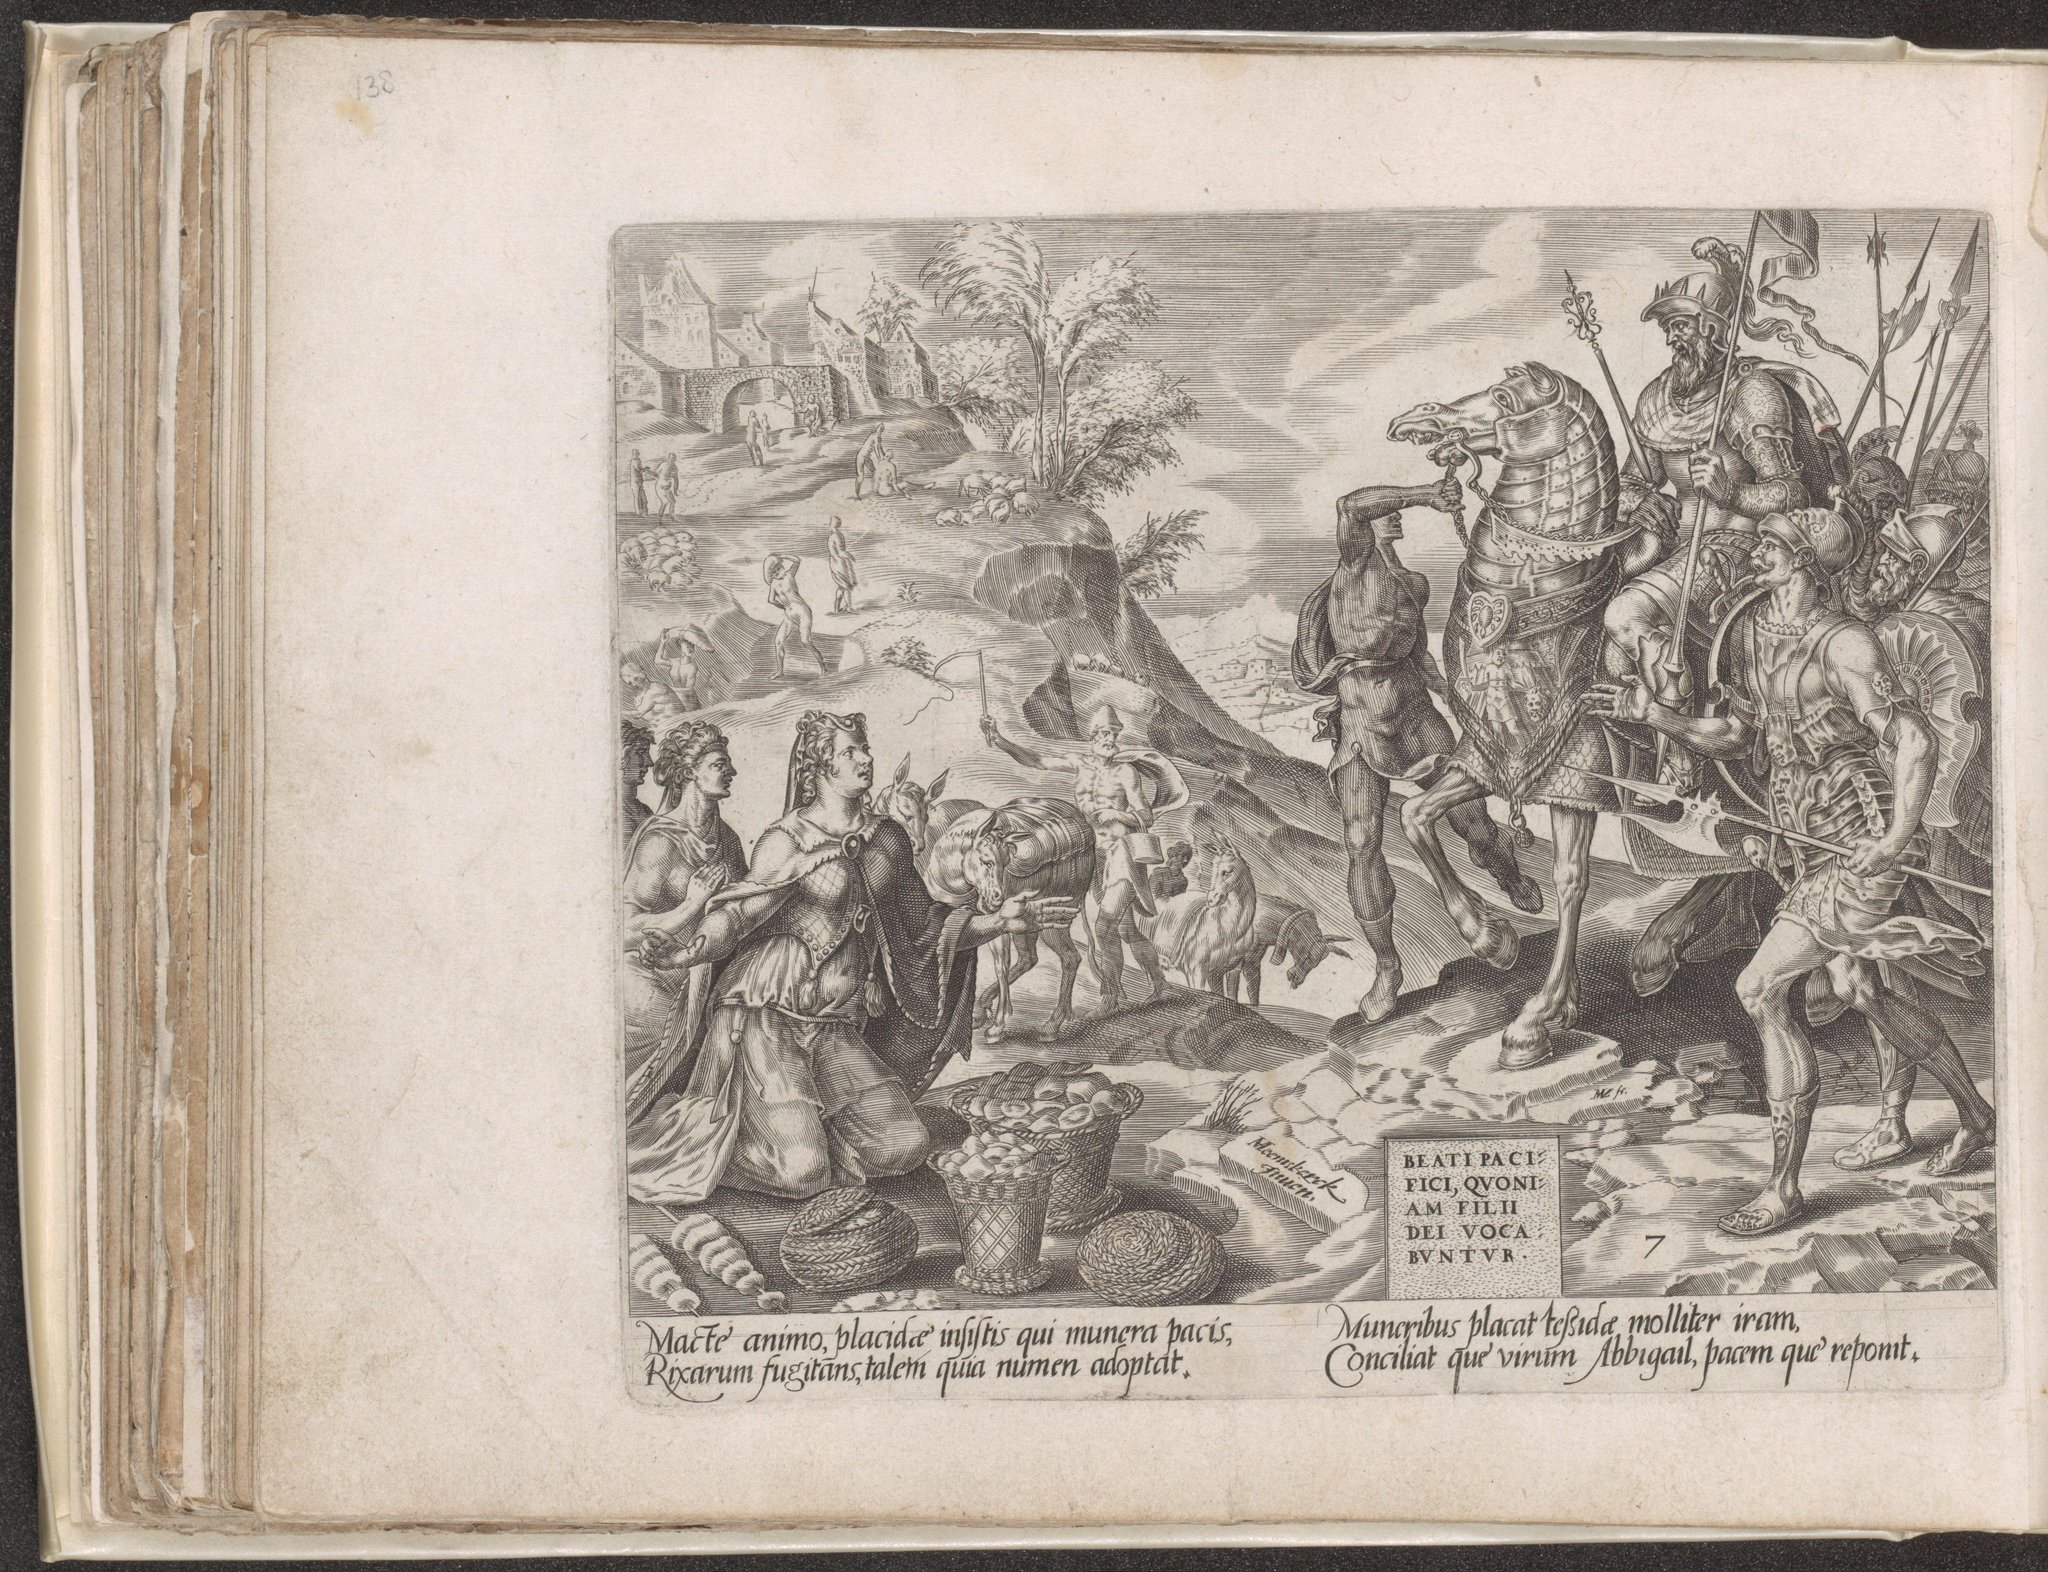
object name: print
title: David en Abigaïl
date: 1564-1568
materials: paper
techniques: engraving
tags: blessed are the peacemakers, meeting of david and abigail, who kneels before him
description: Wanneer een gierige boer weigert David en zijn manschappen te helpen, dreigen ze hem te straffen. Abigaïl, de vrouw van de boer, knielt voor David en biedt hem en zijn soldaten eten en drinken aan. Daarmee stemde ze David tevreden. Prent maakt deel uit van een serie over de acht zaligsprekingen van Christus en illustreert de zaligspreking: Zalig de vredestichters. Op een vierkant plakaat onderaan deze tekst uit Mat. 5:9 in het Latijn. Onderaan in de marge een vers in het Latijn over de zaligspreking en de voorstelling. Deze prent maakt deel uit van een album.